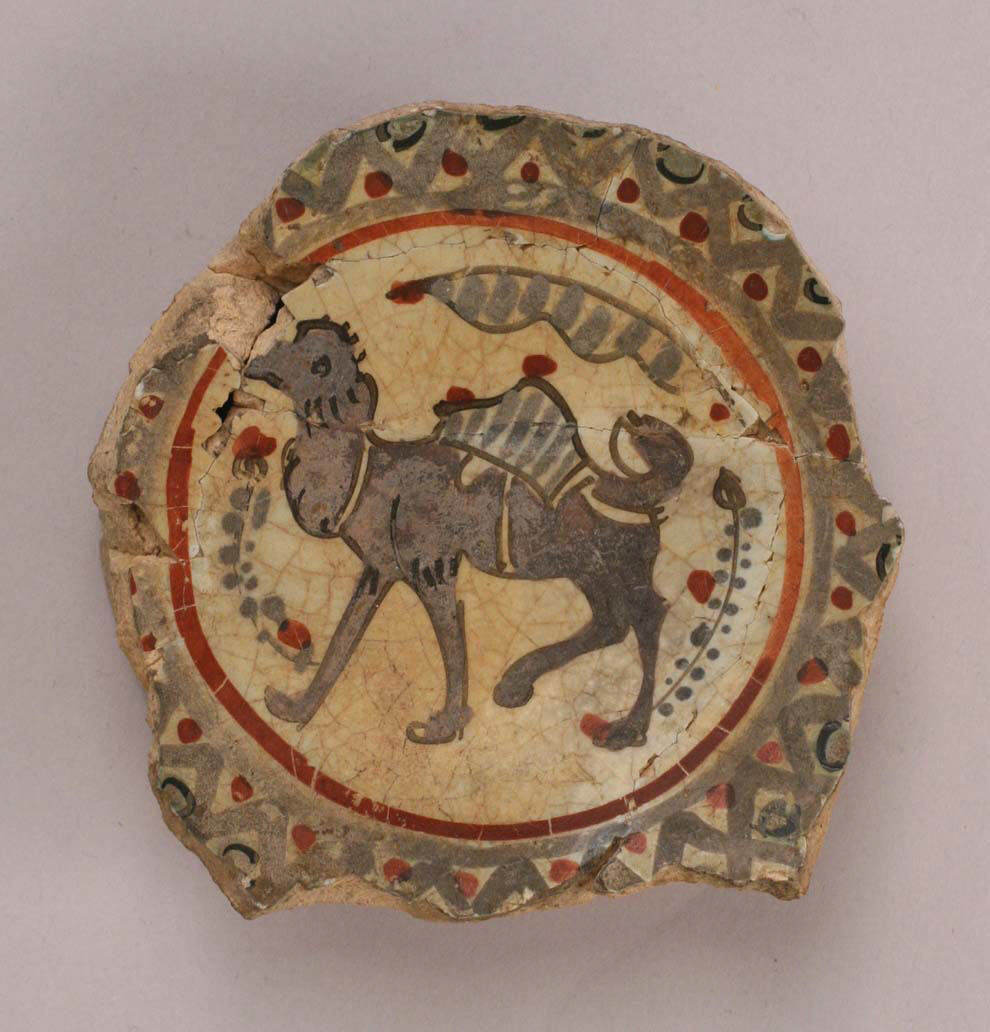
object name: fragment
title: Fragment of a Bowl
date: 1101-1300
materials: stonepaste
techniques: overglaze, painting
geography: iran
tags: camels